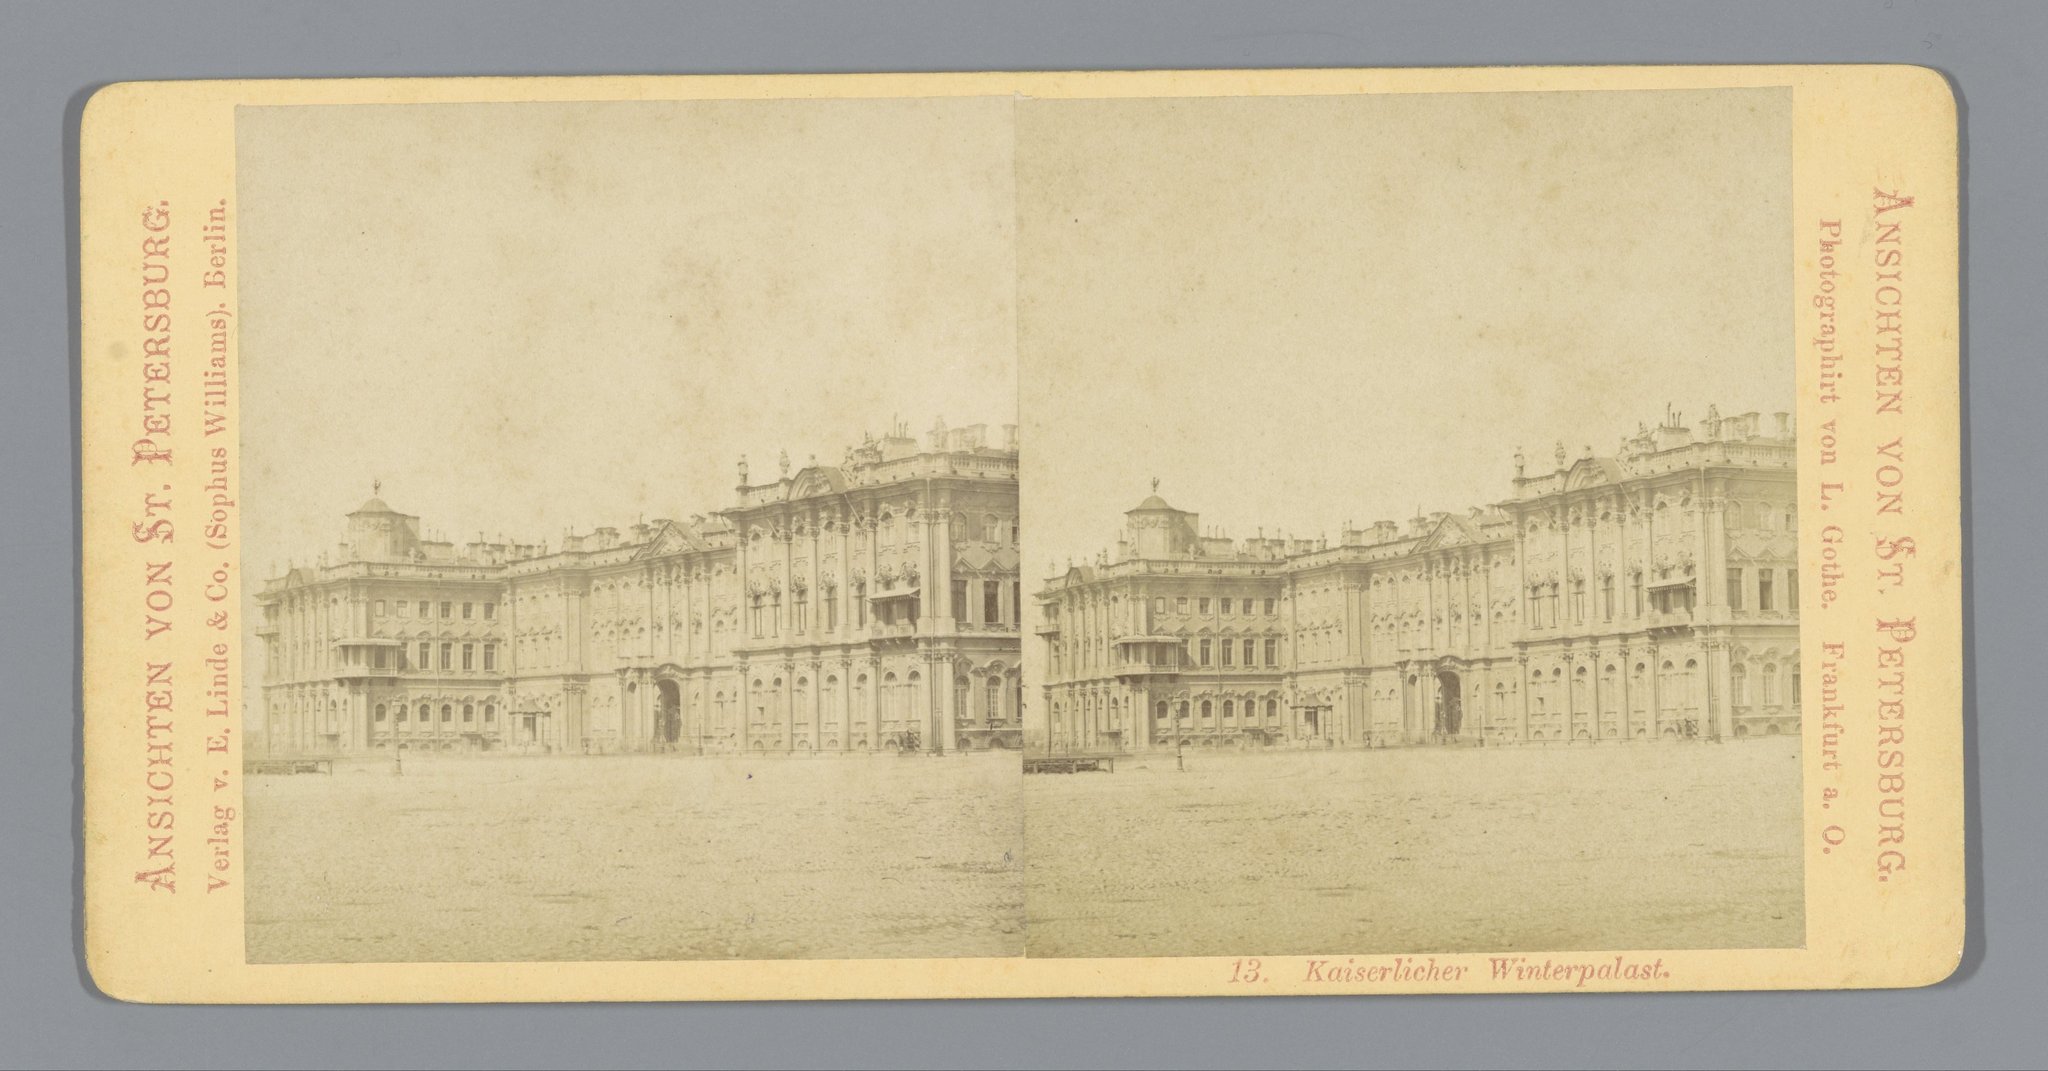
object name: stereograph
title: Gezicht op het Winterpaleis in Sint-Petersburg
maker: louis gothe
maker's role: fotograaf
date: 1850-1880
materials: cardboard, photographic support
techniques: albumen print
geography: berlin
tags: palace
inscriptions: number: ‘13.’, inscription: ‘Ansichten von St. Petersburg.’